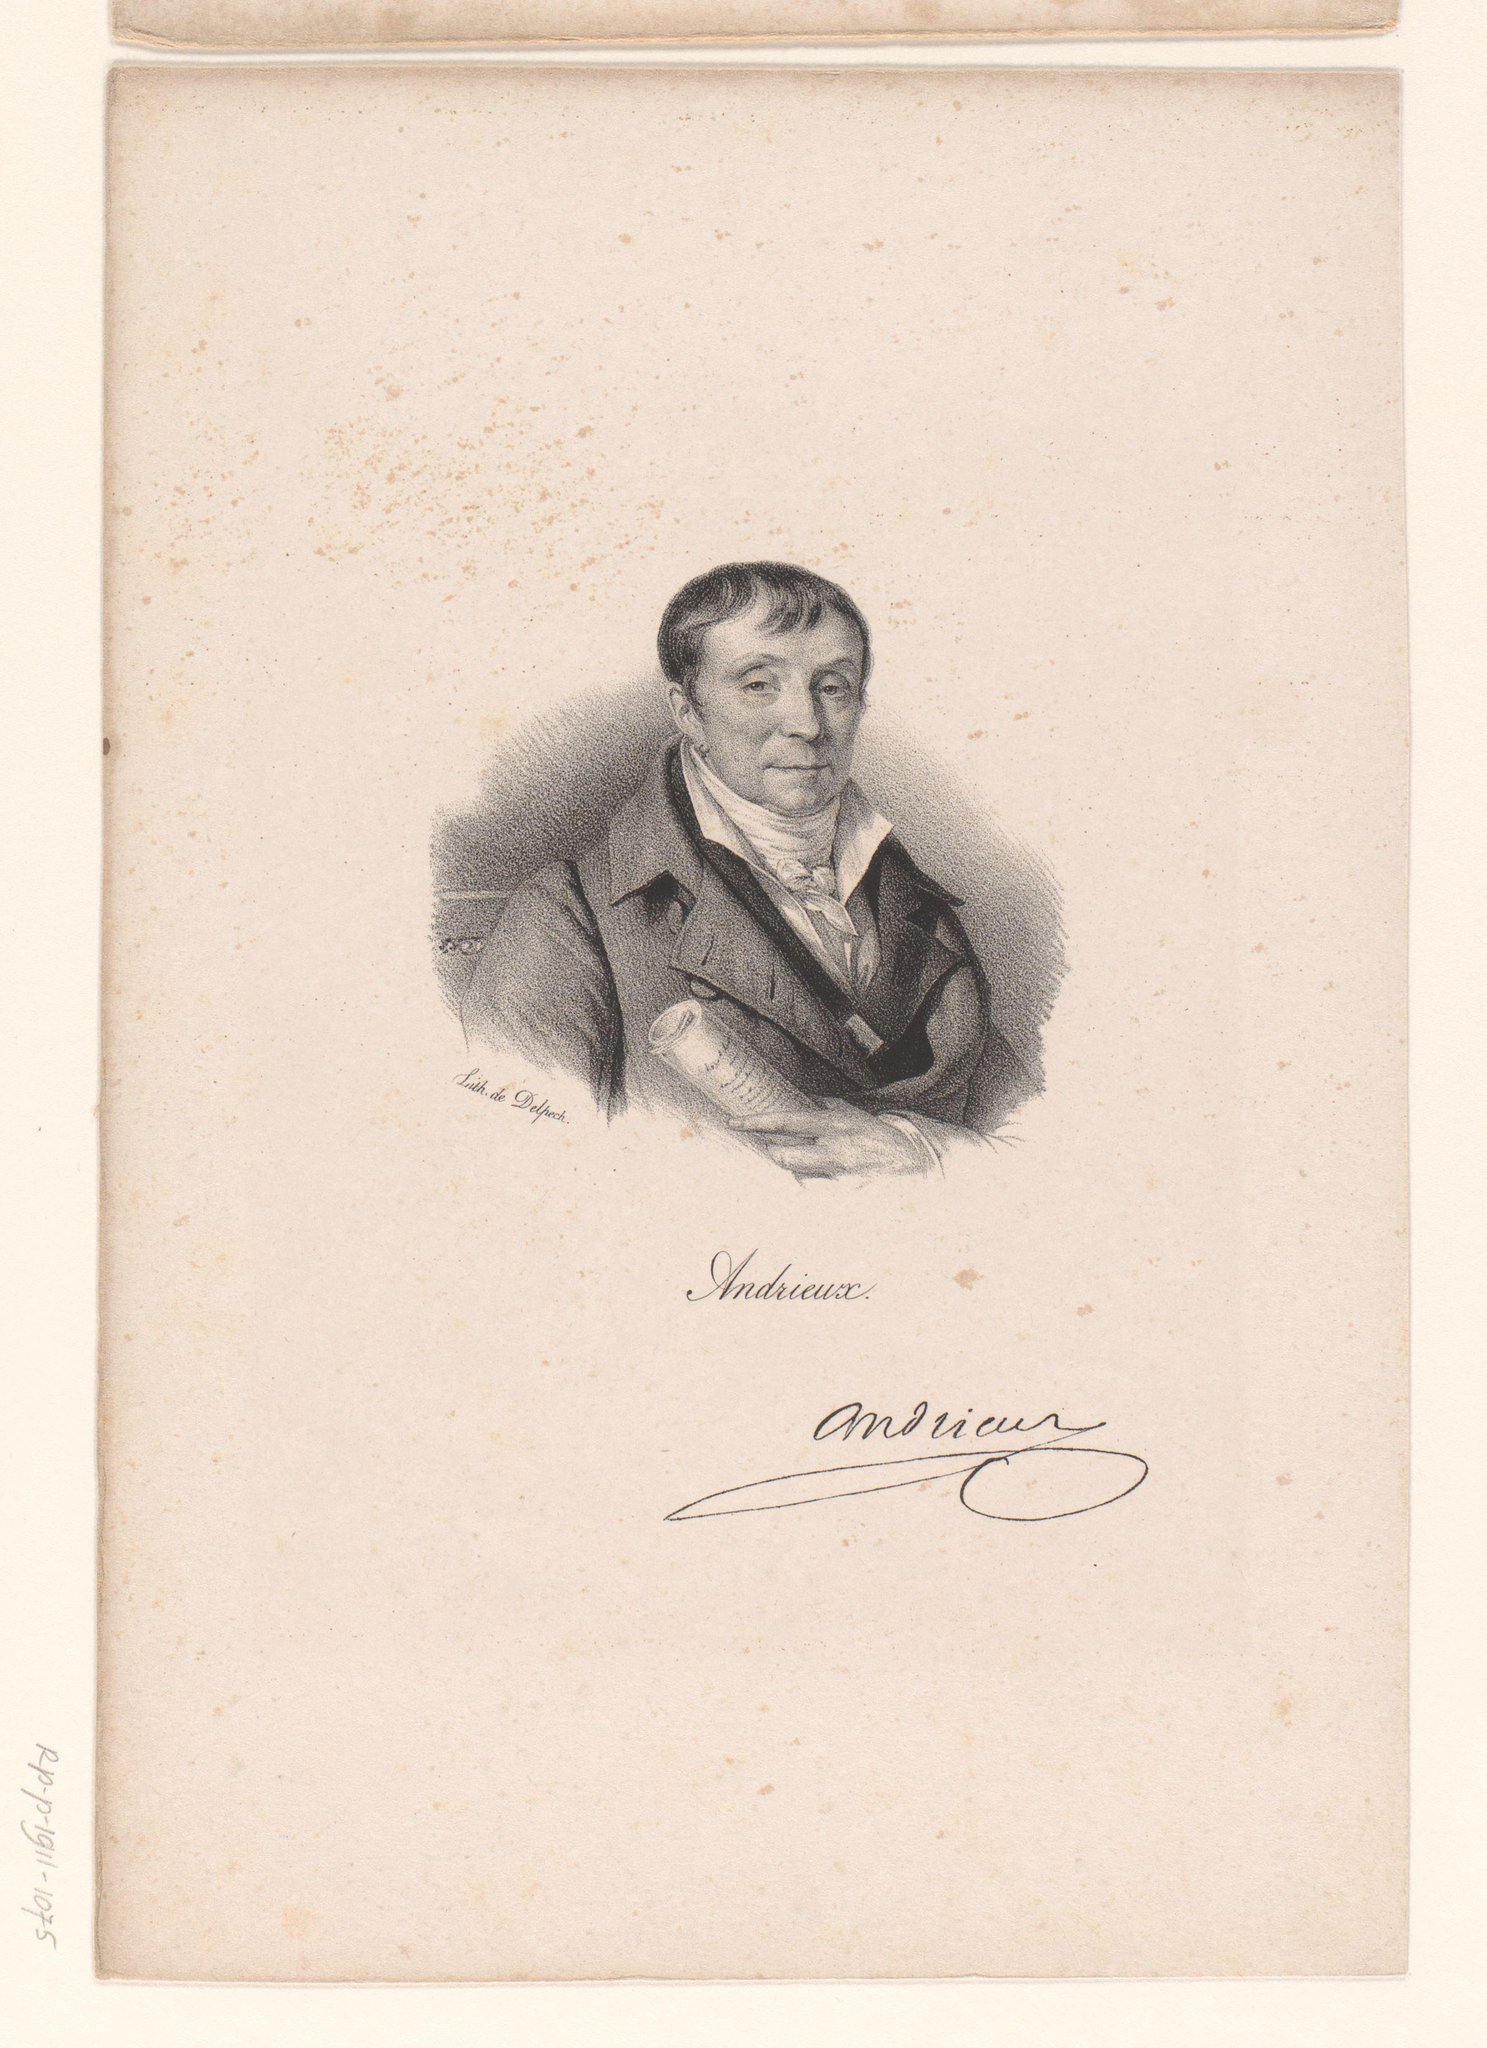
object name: print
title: Portret van François Andrieux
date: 1818-1842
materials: paper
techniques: lithograph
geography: paris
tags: paris, historical persons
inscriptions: collector's mark: Lugt 2228a